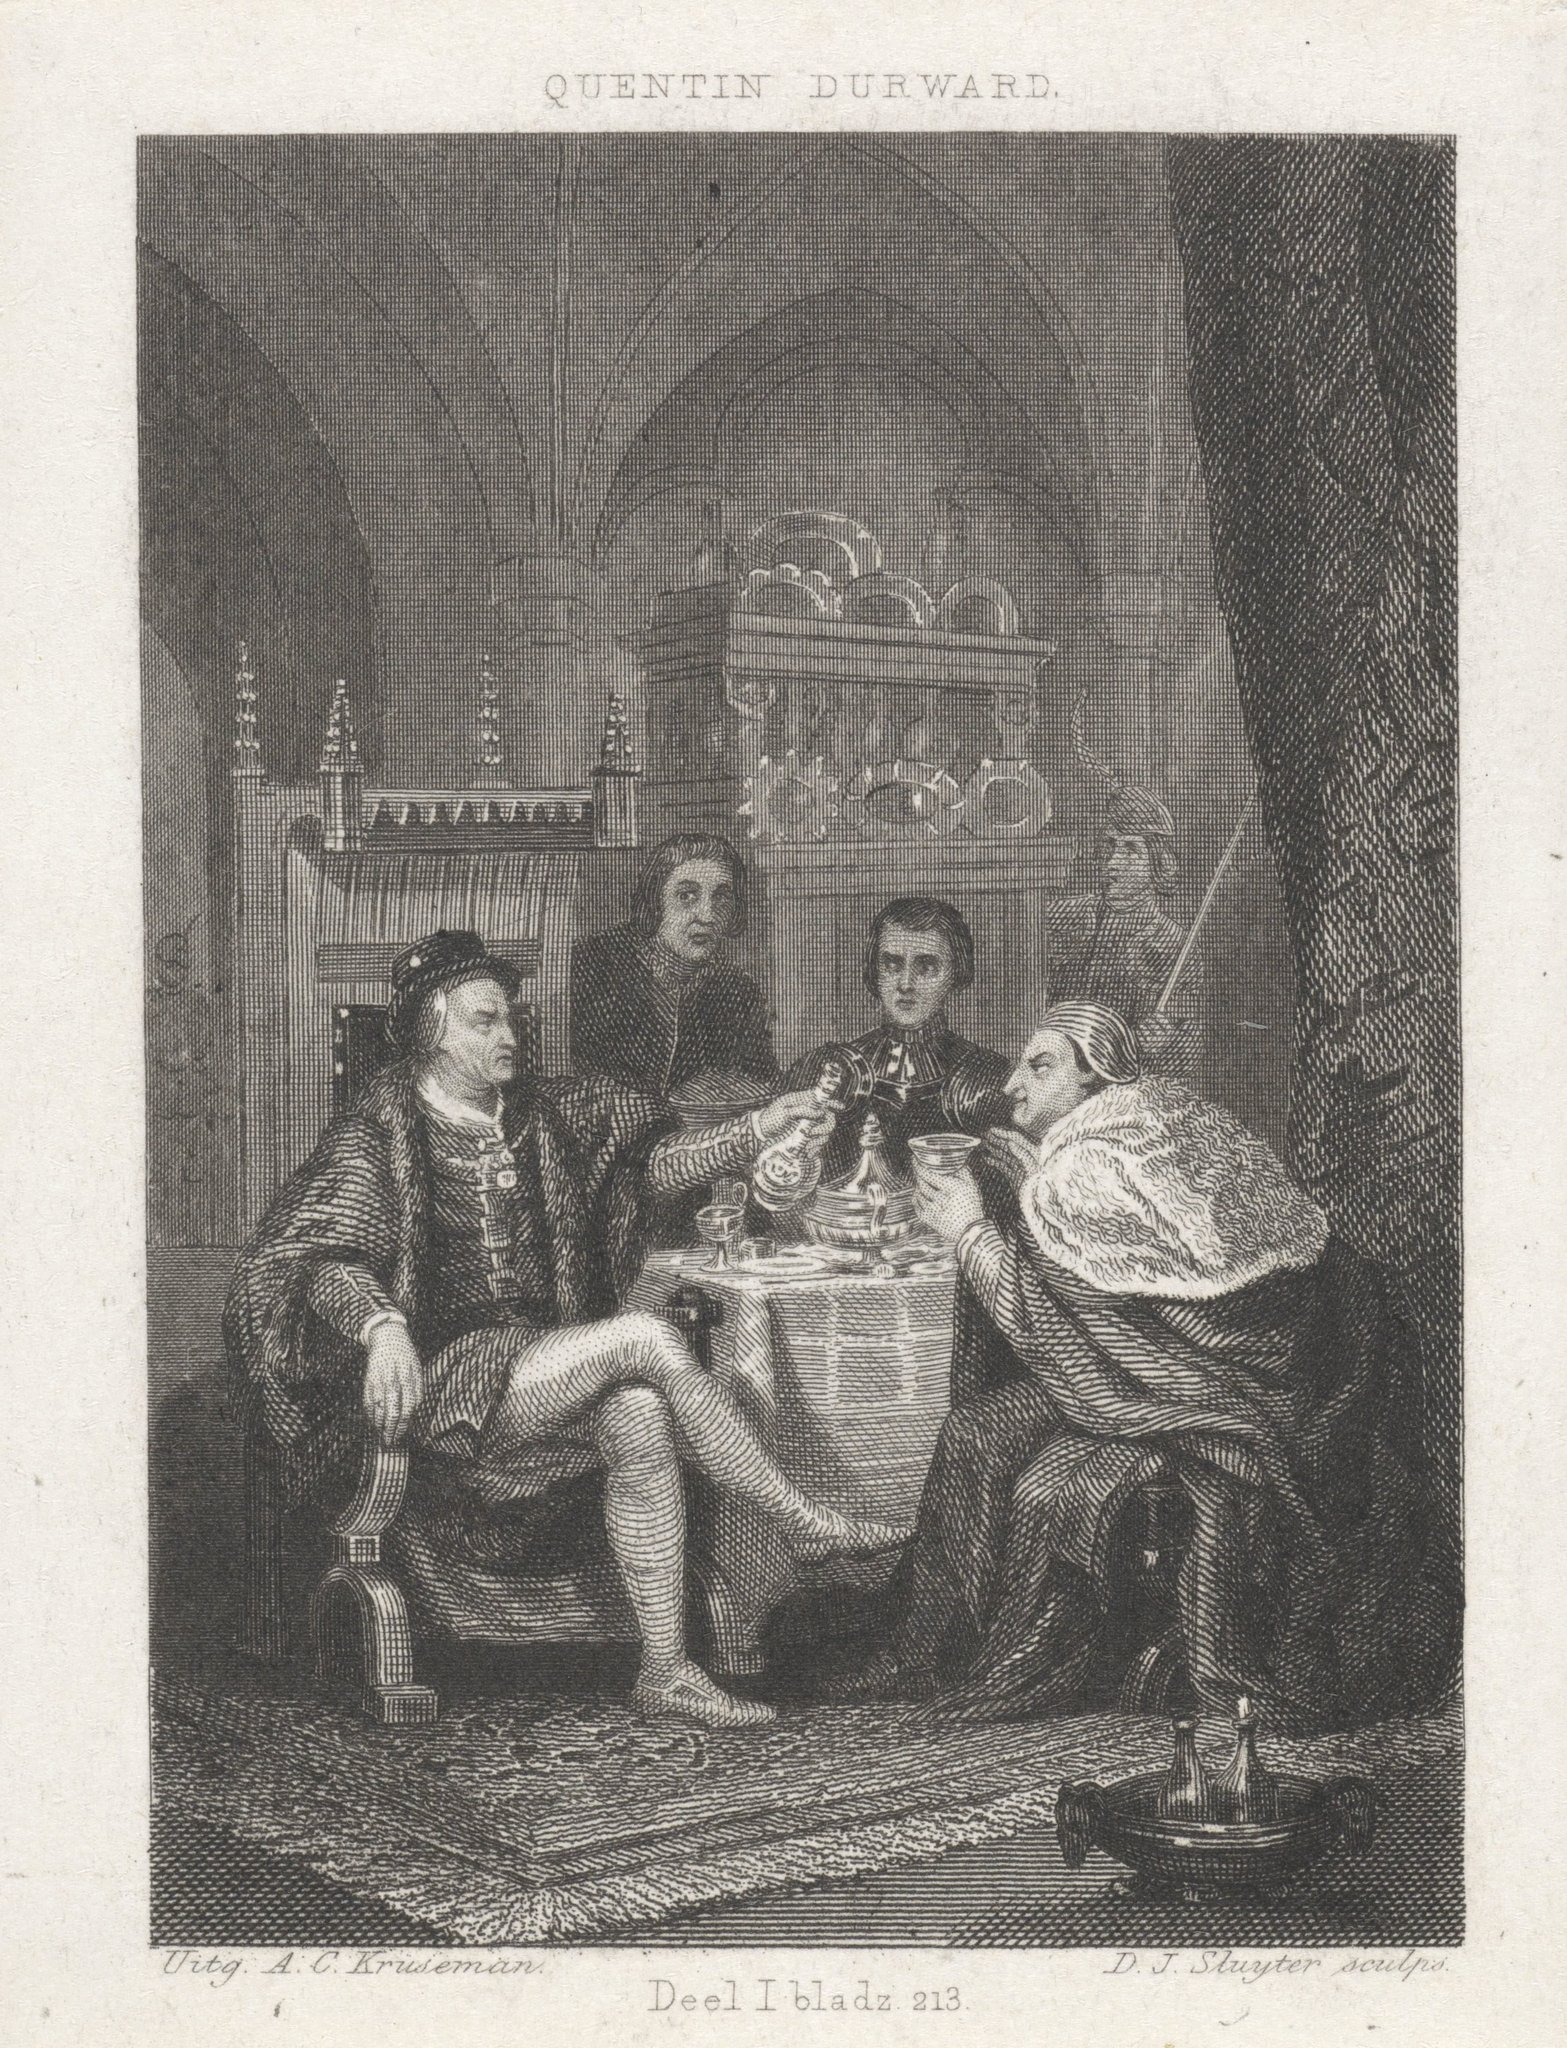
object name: print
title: Gezelschap aan tafel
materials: paper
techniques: engraving, etching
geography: amsterdam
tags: wine-cooler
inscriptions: collector's mark: Lugt 2228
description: Een edelman op een rijk bewerkte stoel schenkt een kardinaal wijn bij. Zij zitten aan een tafel waarop glazen en een wijnkoeler staan. Op de grond staat een tweede wijnkoeler. Twee mannen kijken toe vanaf de andere zijde van de tafel. Boven de afbeelding de titel van het boek, eronder een verwijzing naar de bladzijde waarbij de illustratie hoort.